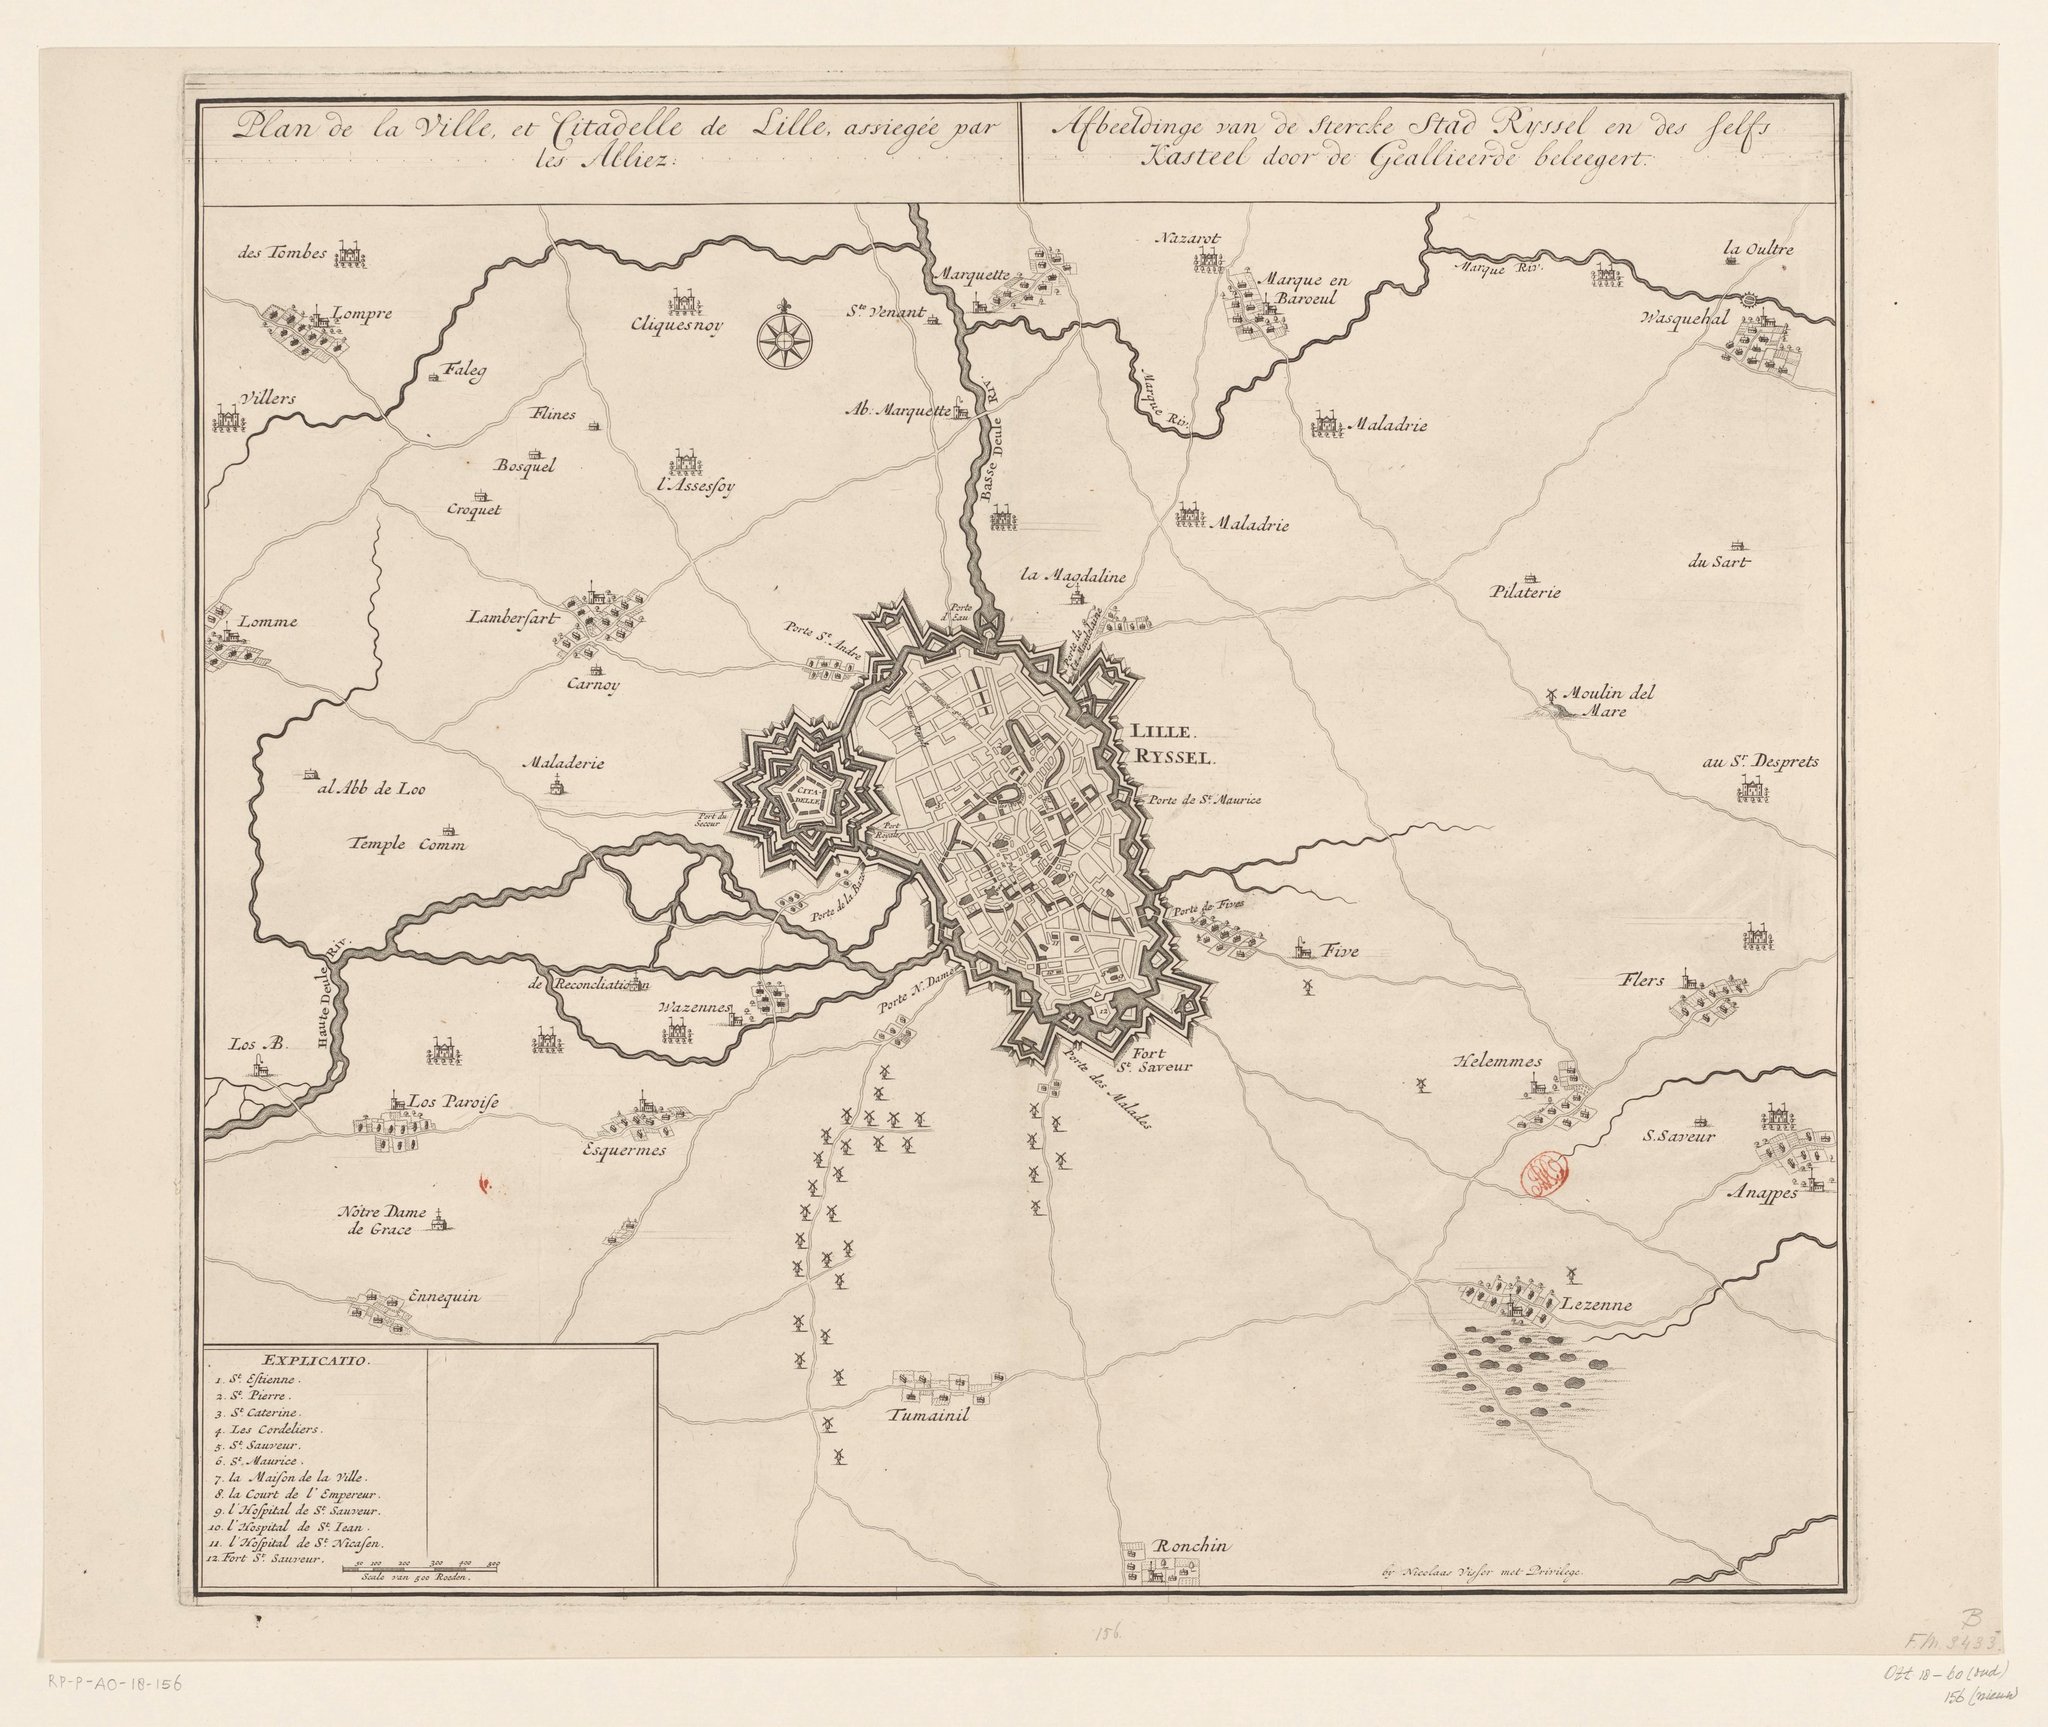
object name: map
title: Plan de la Ville, et Citadelle de Lille, assiegée par les Alliez / Afbeeldinge van de stercke Stad Ryssel en des selfs Kasteel door de Geallieerde beleegert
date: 1708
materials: paper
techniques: etching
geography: amsterdam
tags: siege, position war, maps of cities, lille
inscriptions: collector's mark: Lugt 195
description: Kaart van Lille, belegerd door de Geallieerden vanaf 22 augustus 1708. Linksonder de legenda 1-12 in het Frans. In deze staat van de kaart is alleen de stad aangegeven, vóór de omsingeling door de Geallieerden, de landerijen, de rest van titels etc.